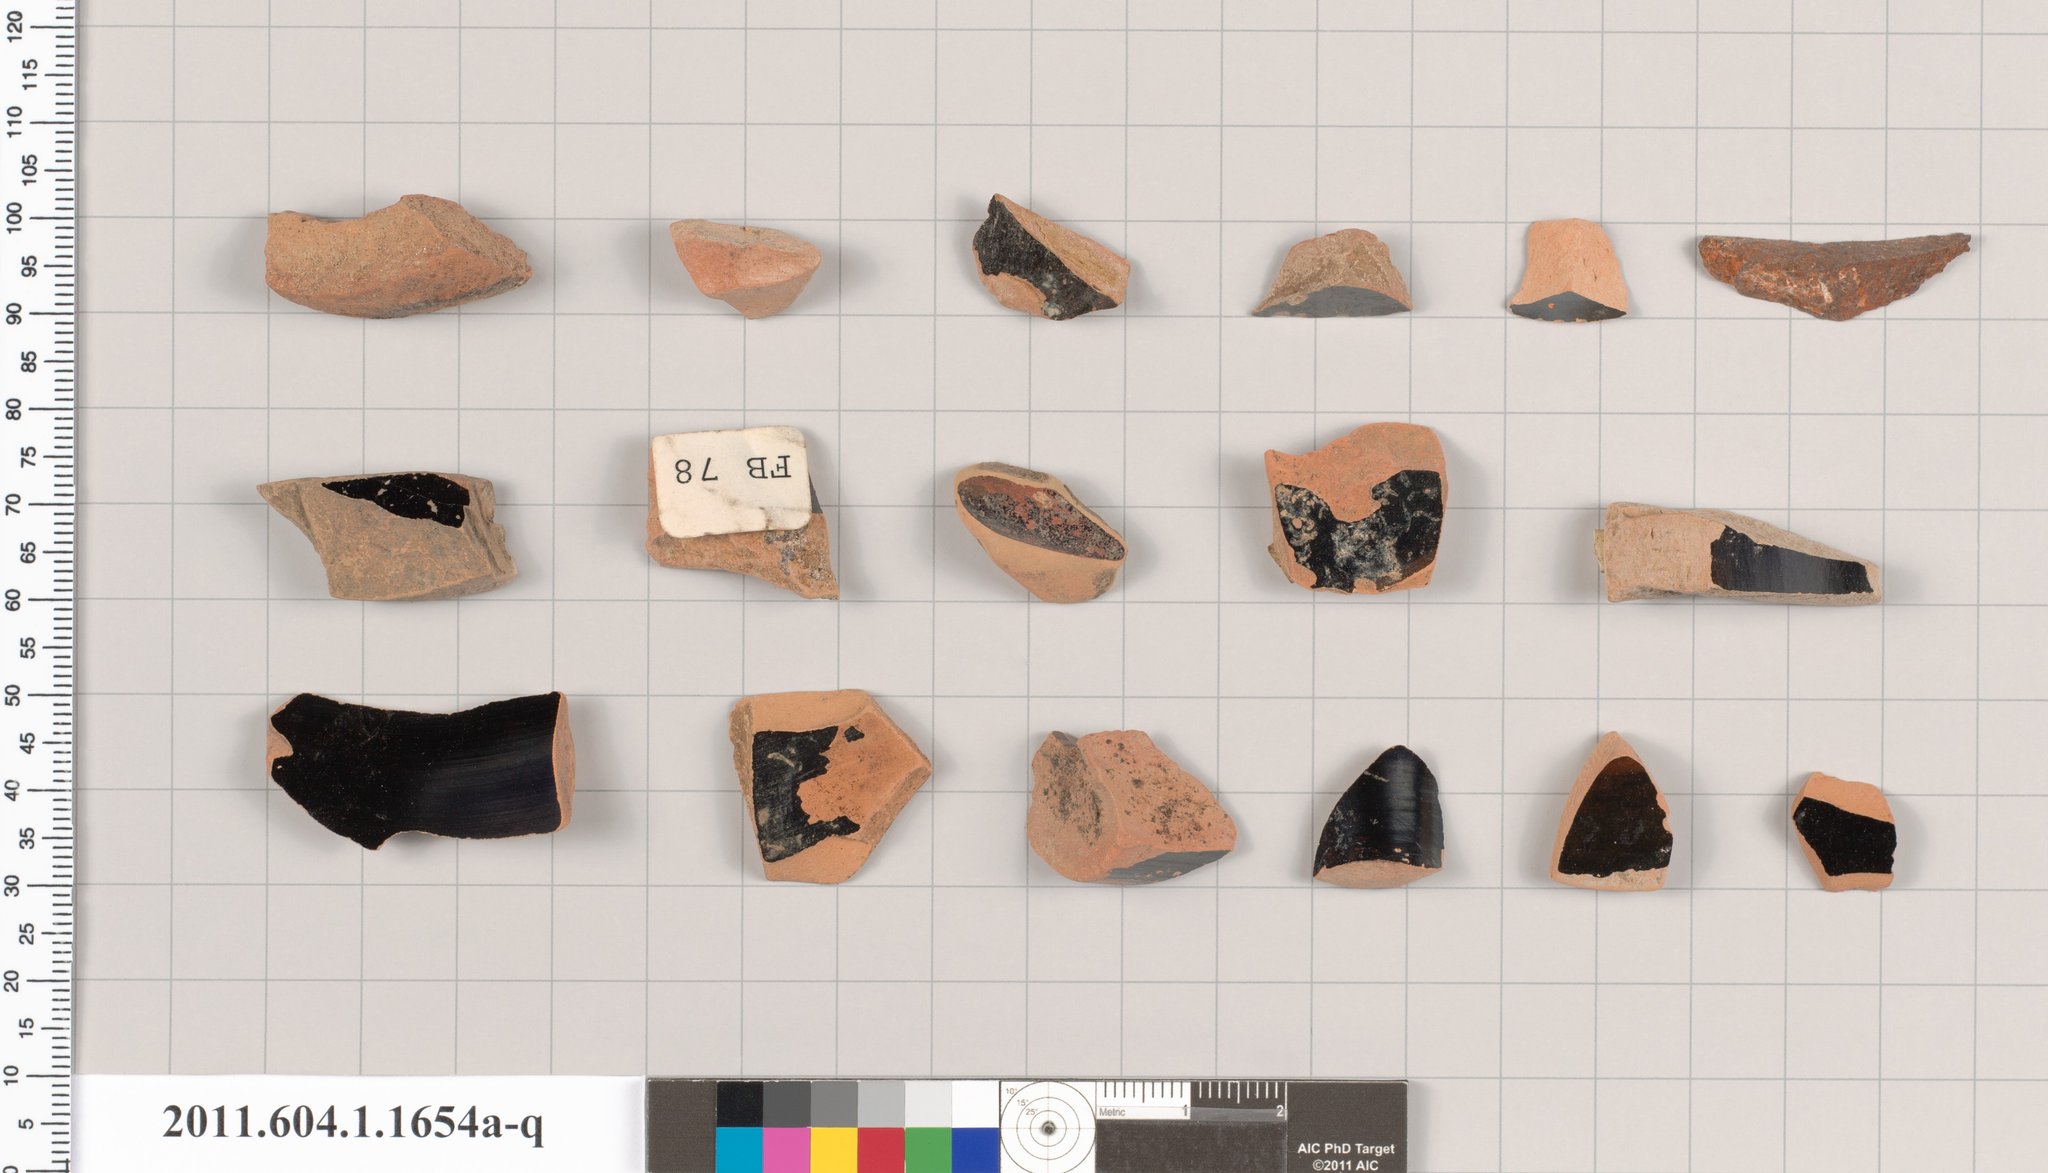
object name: kylix fragment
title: Terracotta fragments of kylikes (drinking cups)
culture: greek, attic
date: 500-401 BCE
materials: terracotta